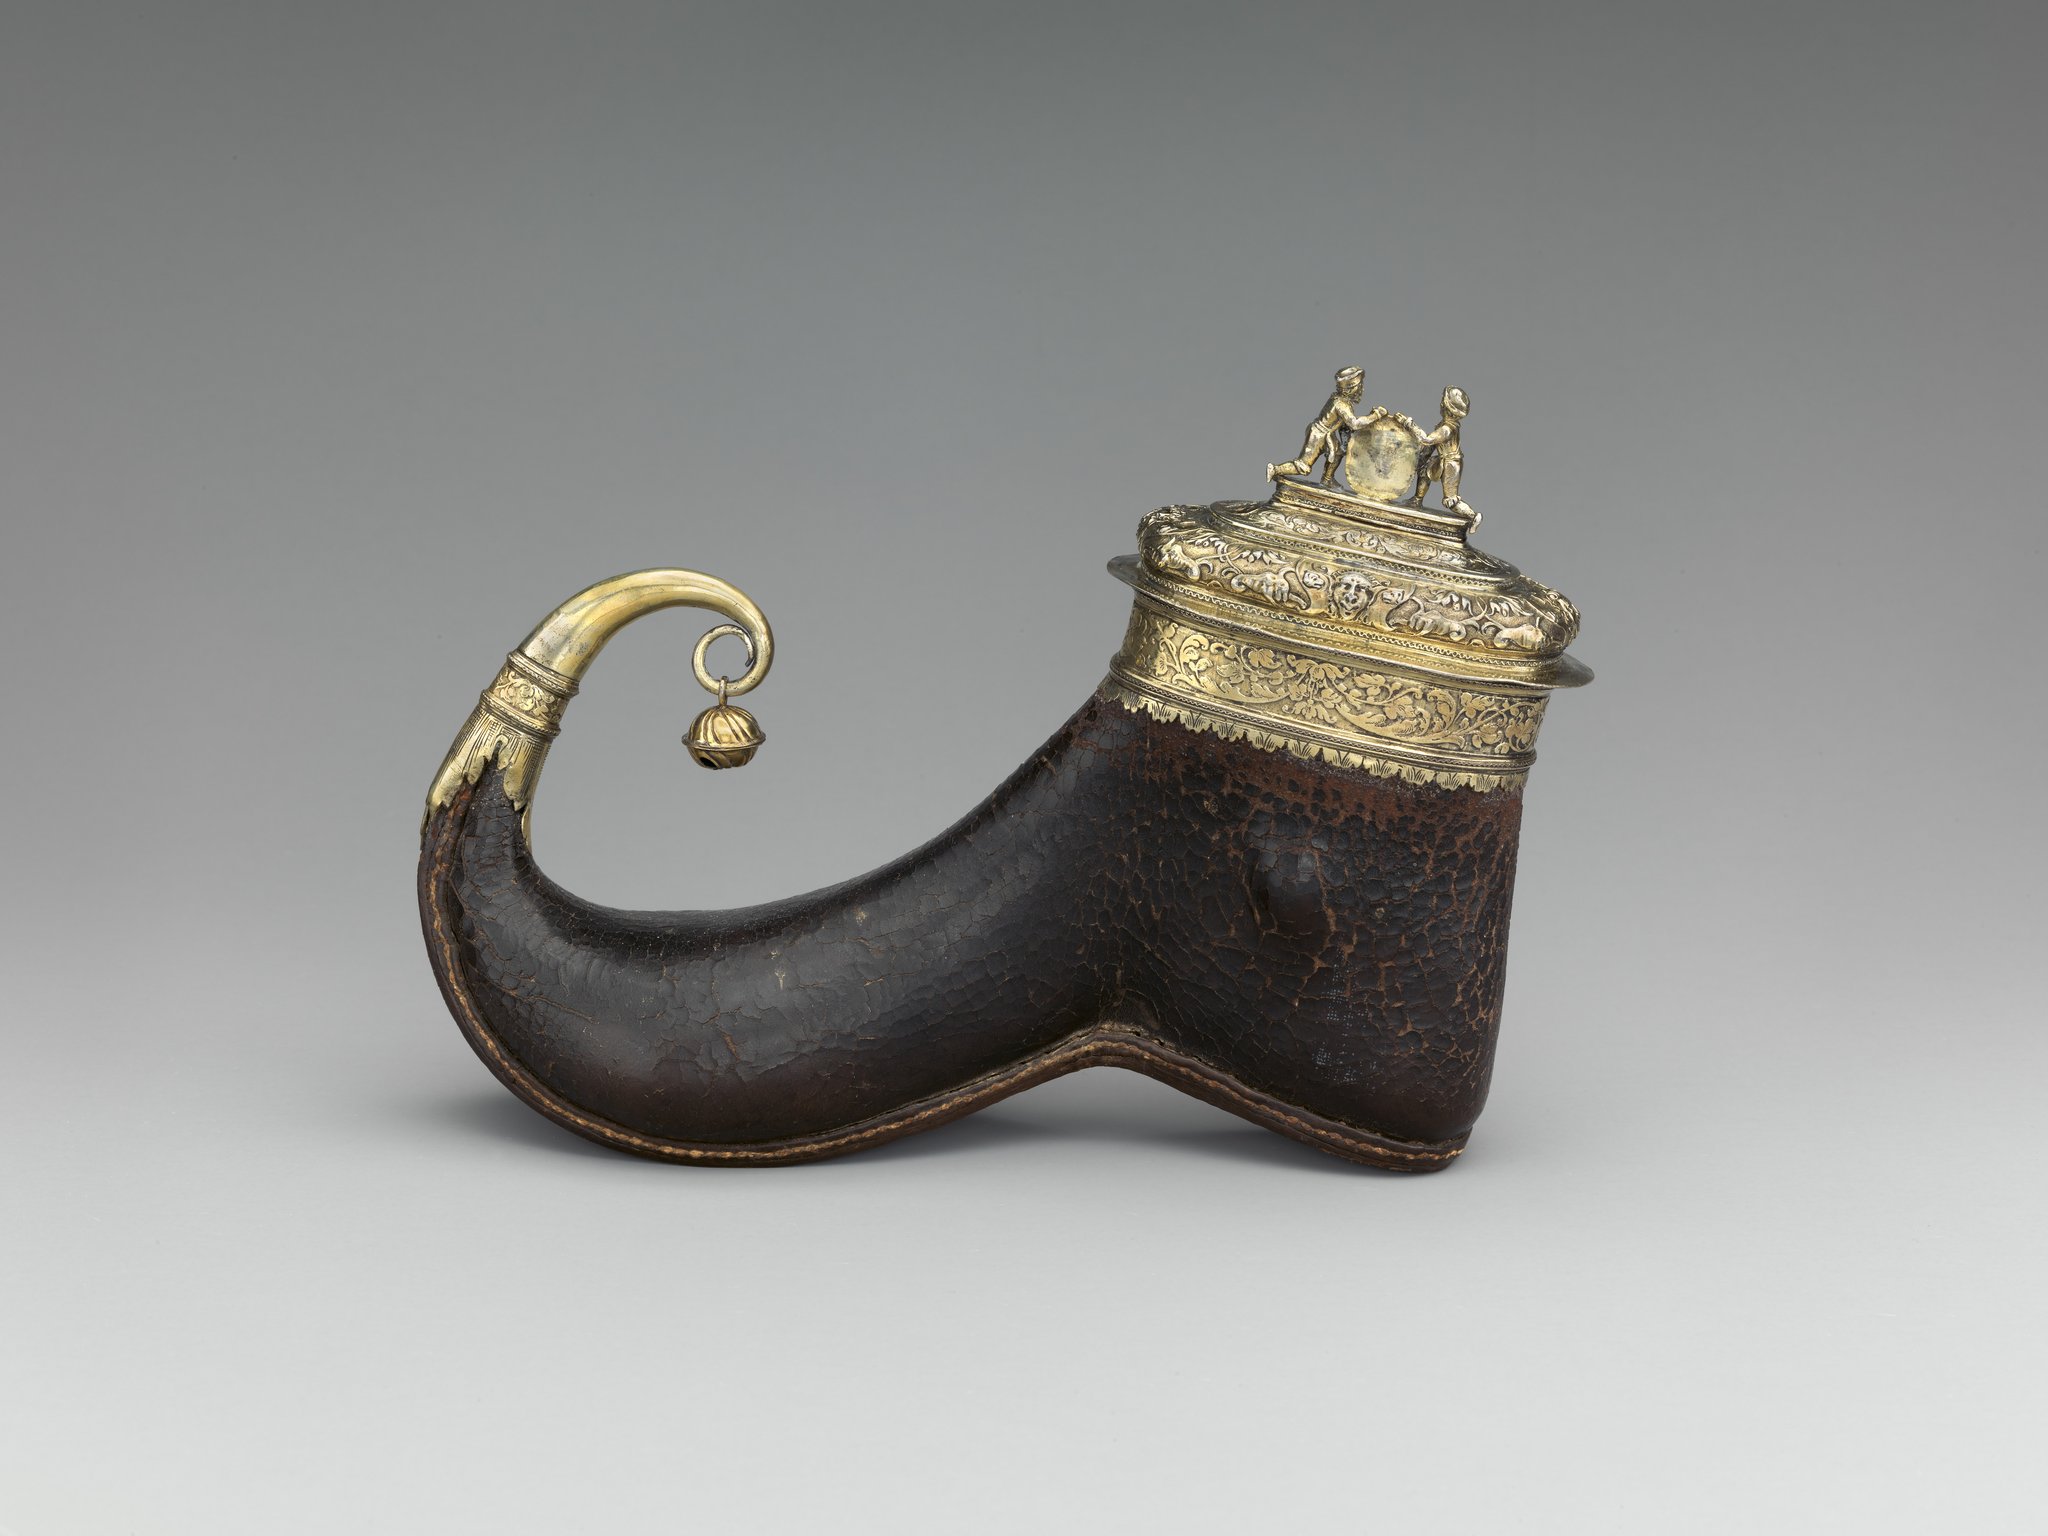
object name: cup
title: Cup in the form of a shoe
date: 1567-1600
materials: leather, silver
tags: human figures,shoes